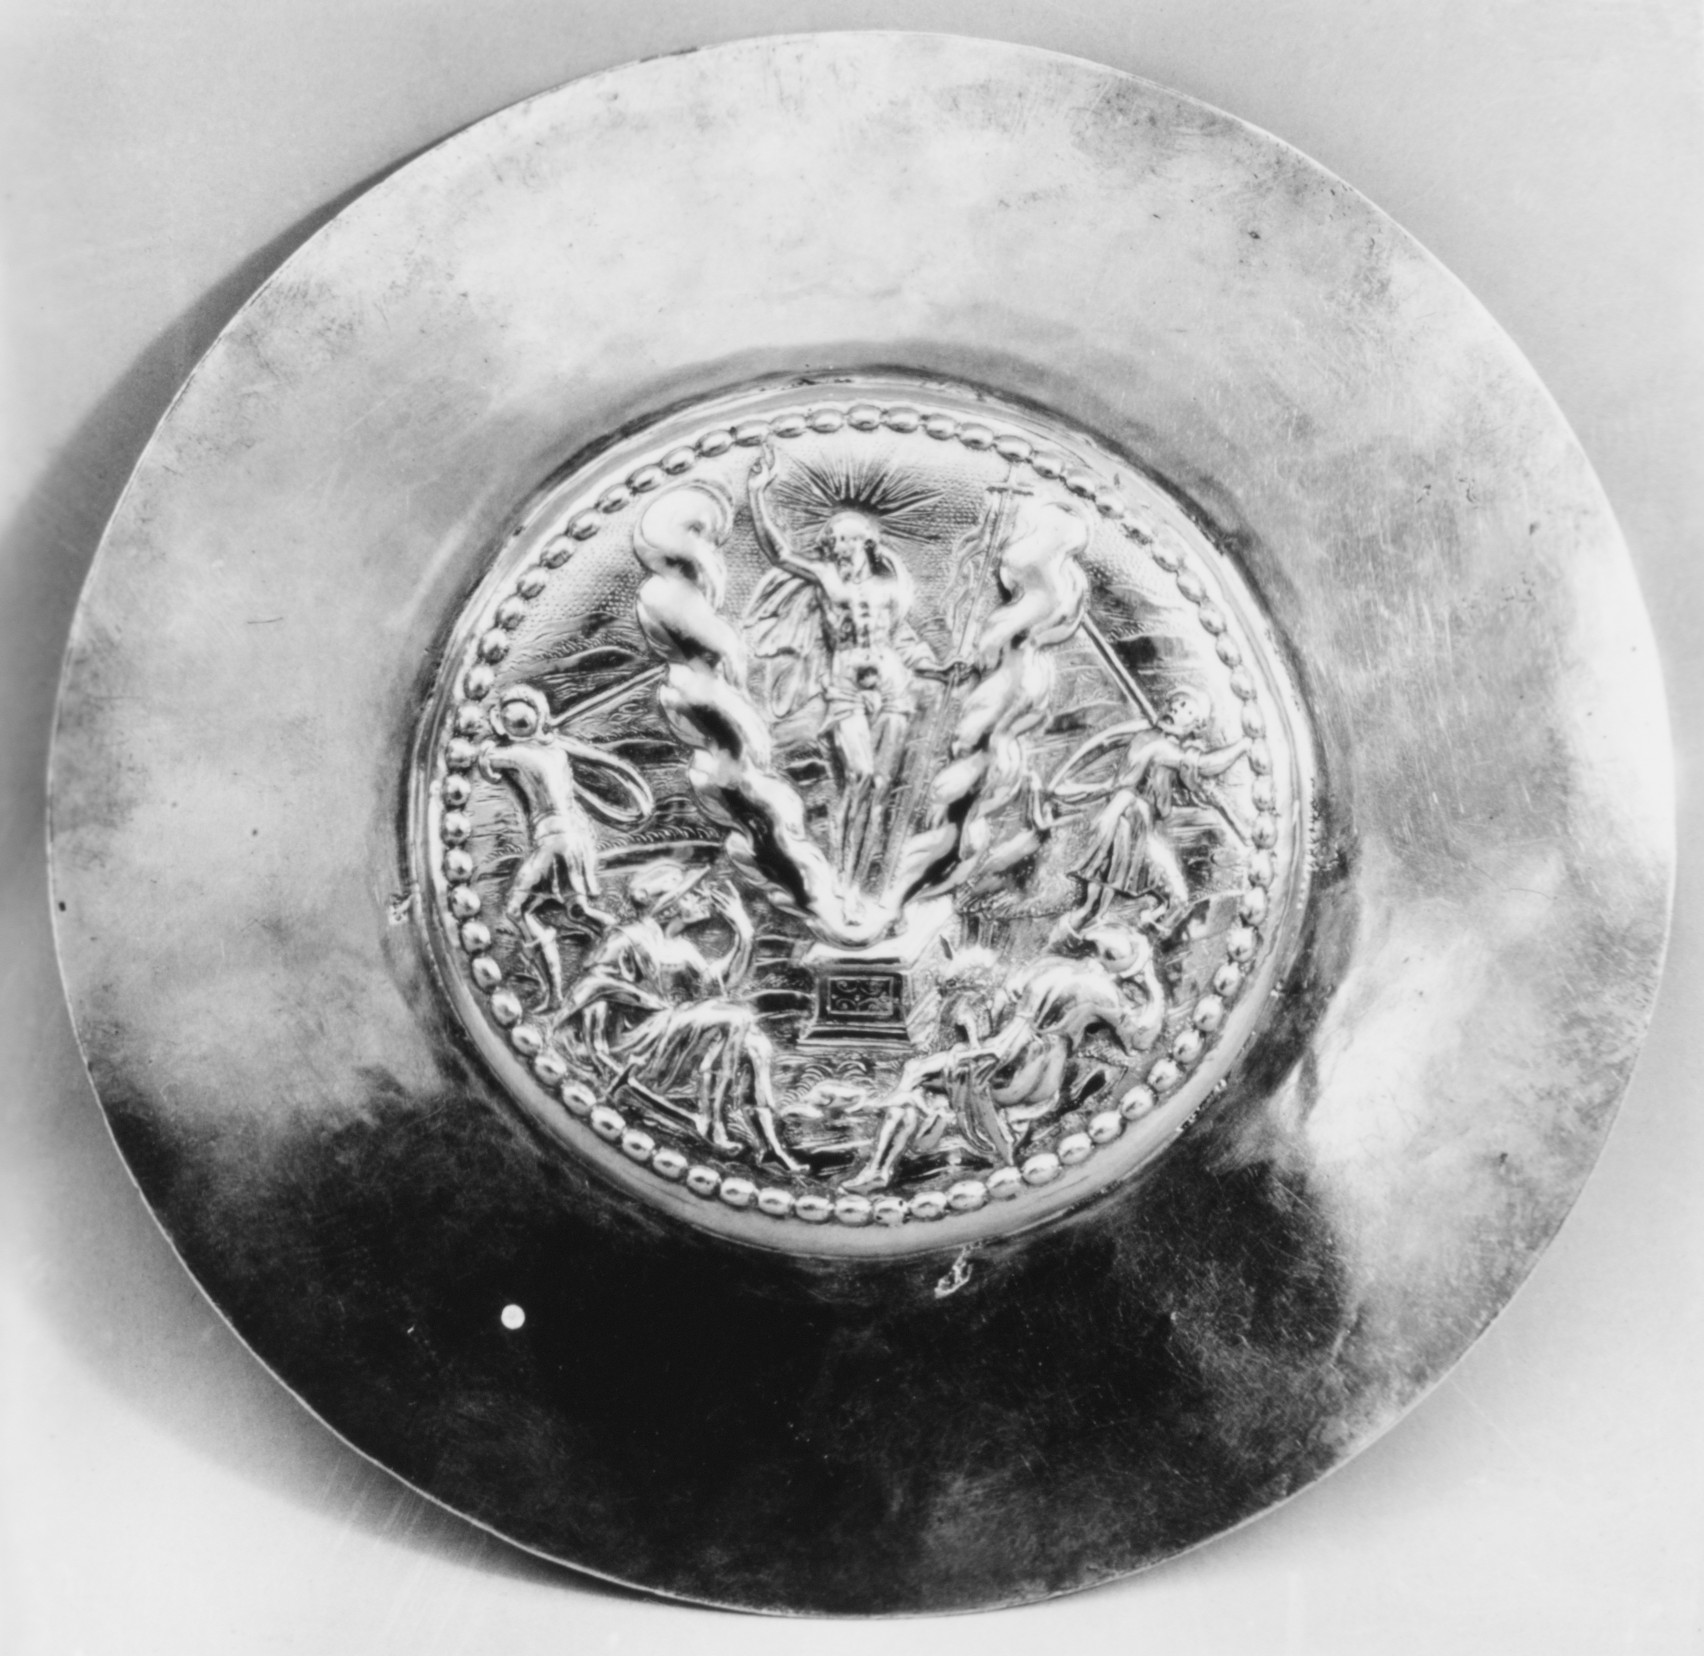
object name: paten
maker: adam pijart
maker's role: maker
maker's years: 1579-1679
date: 1625-1626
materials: gilt silver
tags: christ